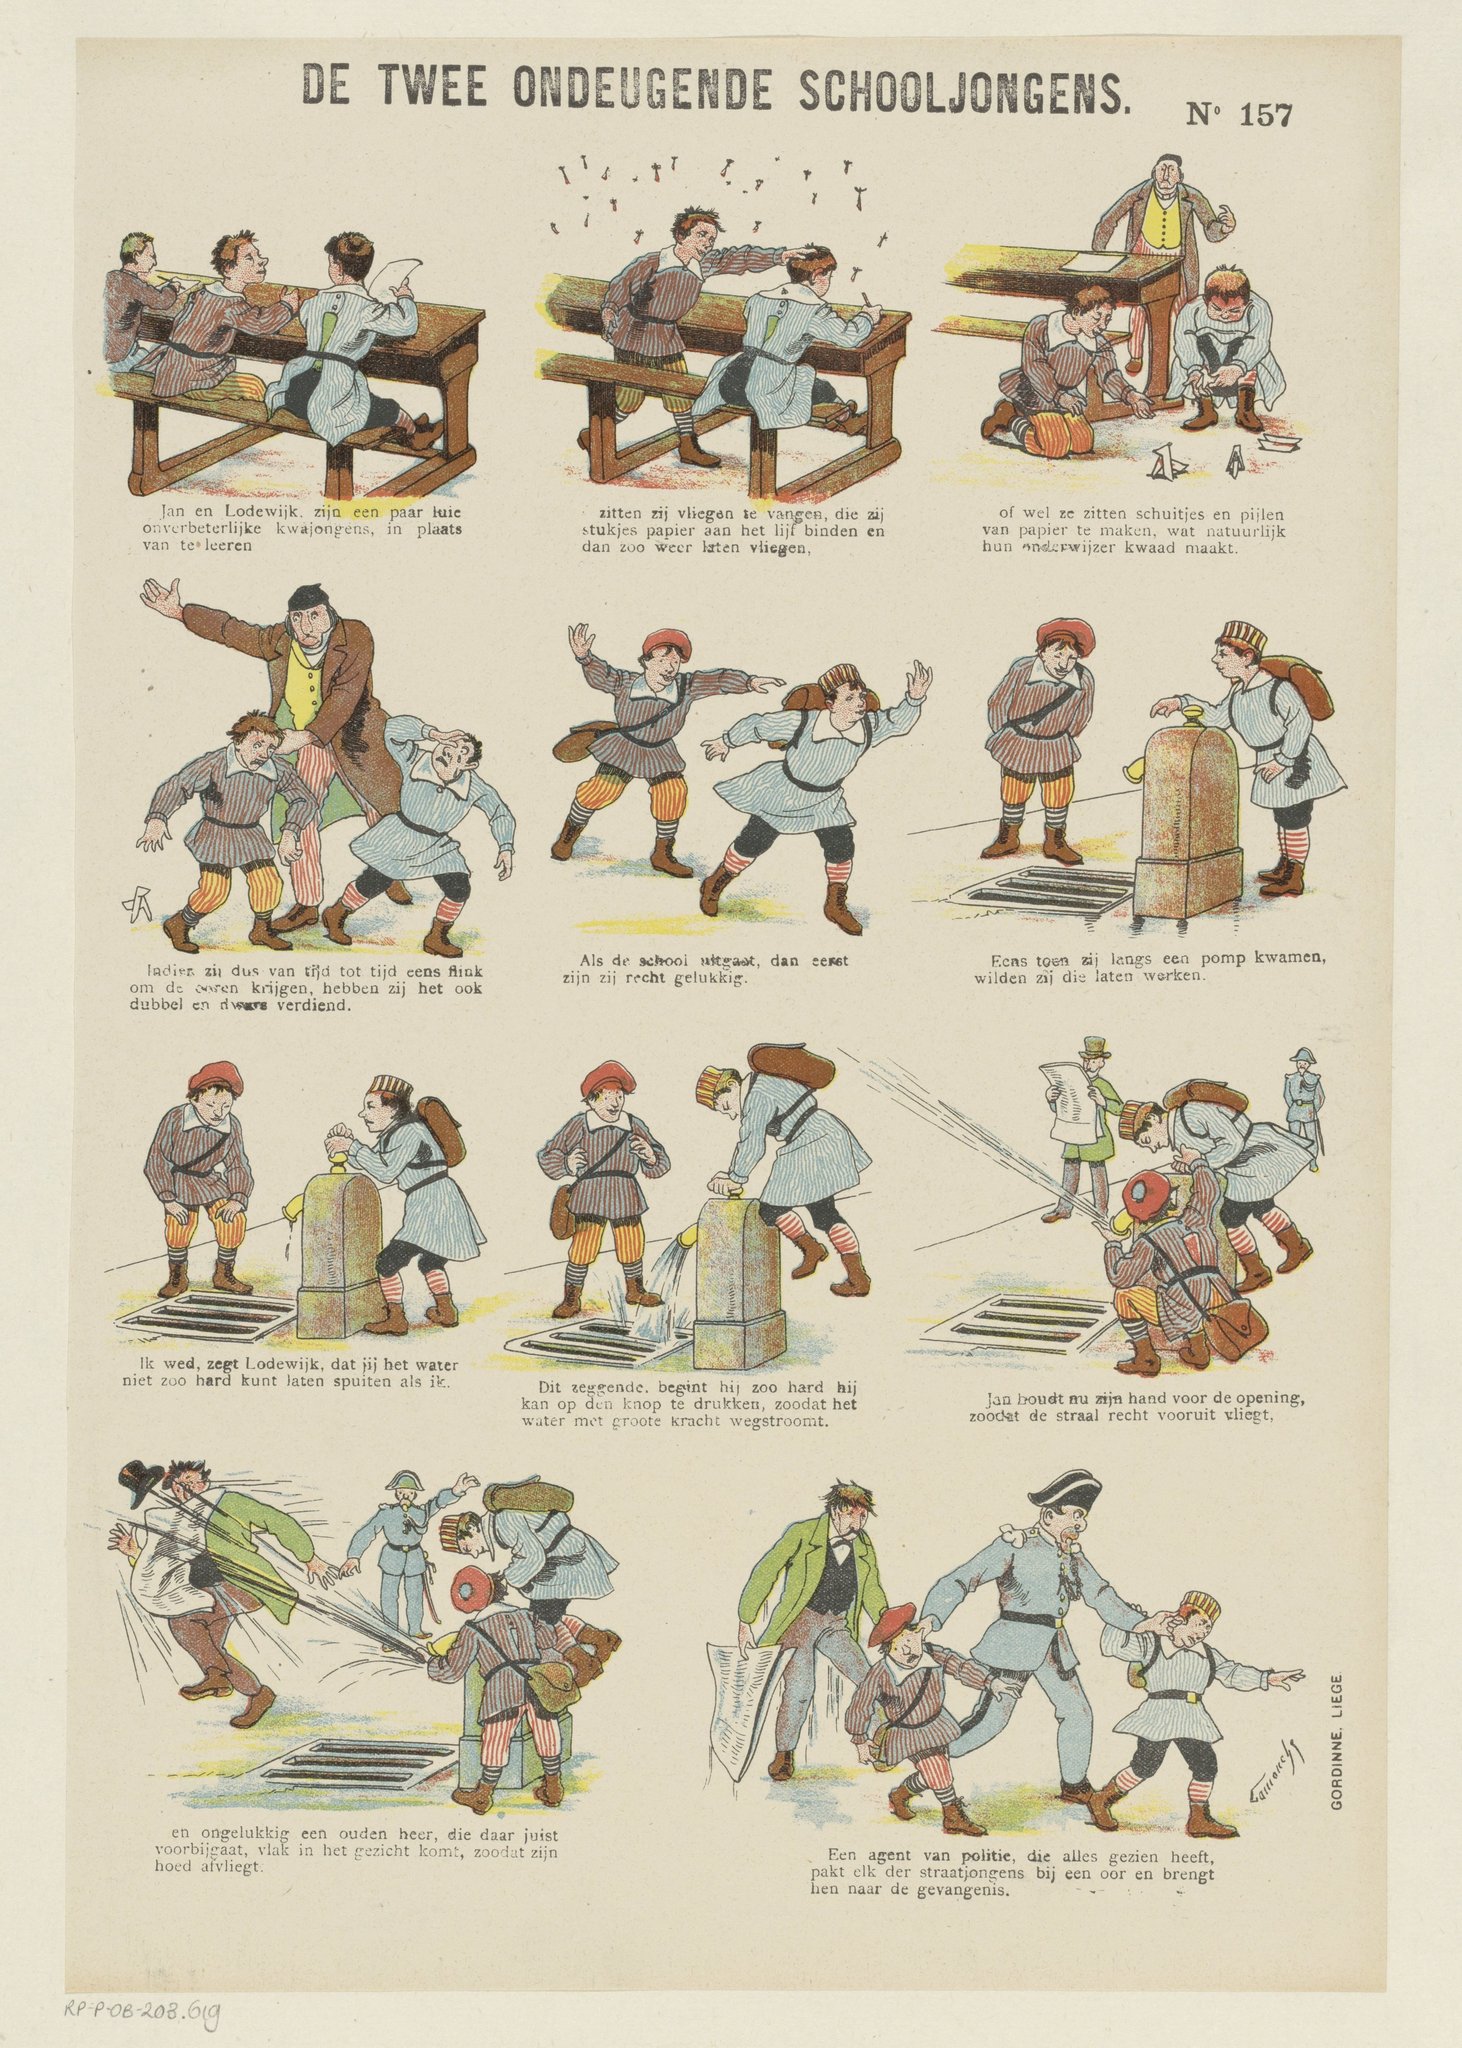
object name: popular print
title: De twee ondeugende schooljongens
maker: lamouche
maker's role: print maker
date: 1894-1959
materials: paper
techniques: lithograph, letterpress printing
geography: liège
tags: mischief-making play, correction of naughty children, bad behaviour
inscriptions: collector's mark: Lugt 2760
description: Blad met 11 voorstellingen over twee ondeugende schooljongens die streken uithalen. Onder elke afbeelding een onderschrift. Genummerd rechtsboven: No 157.